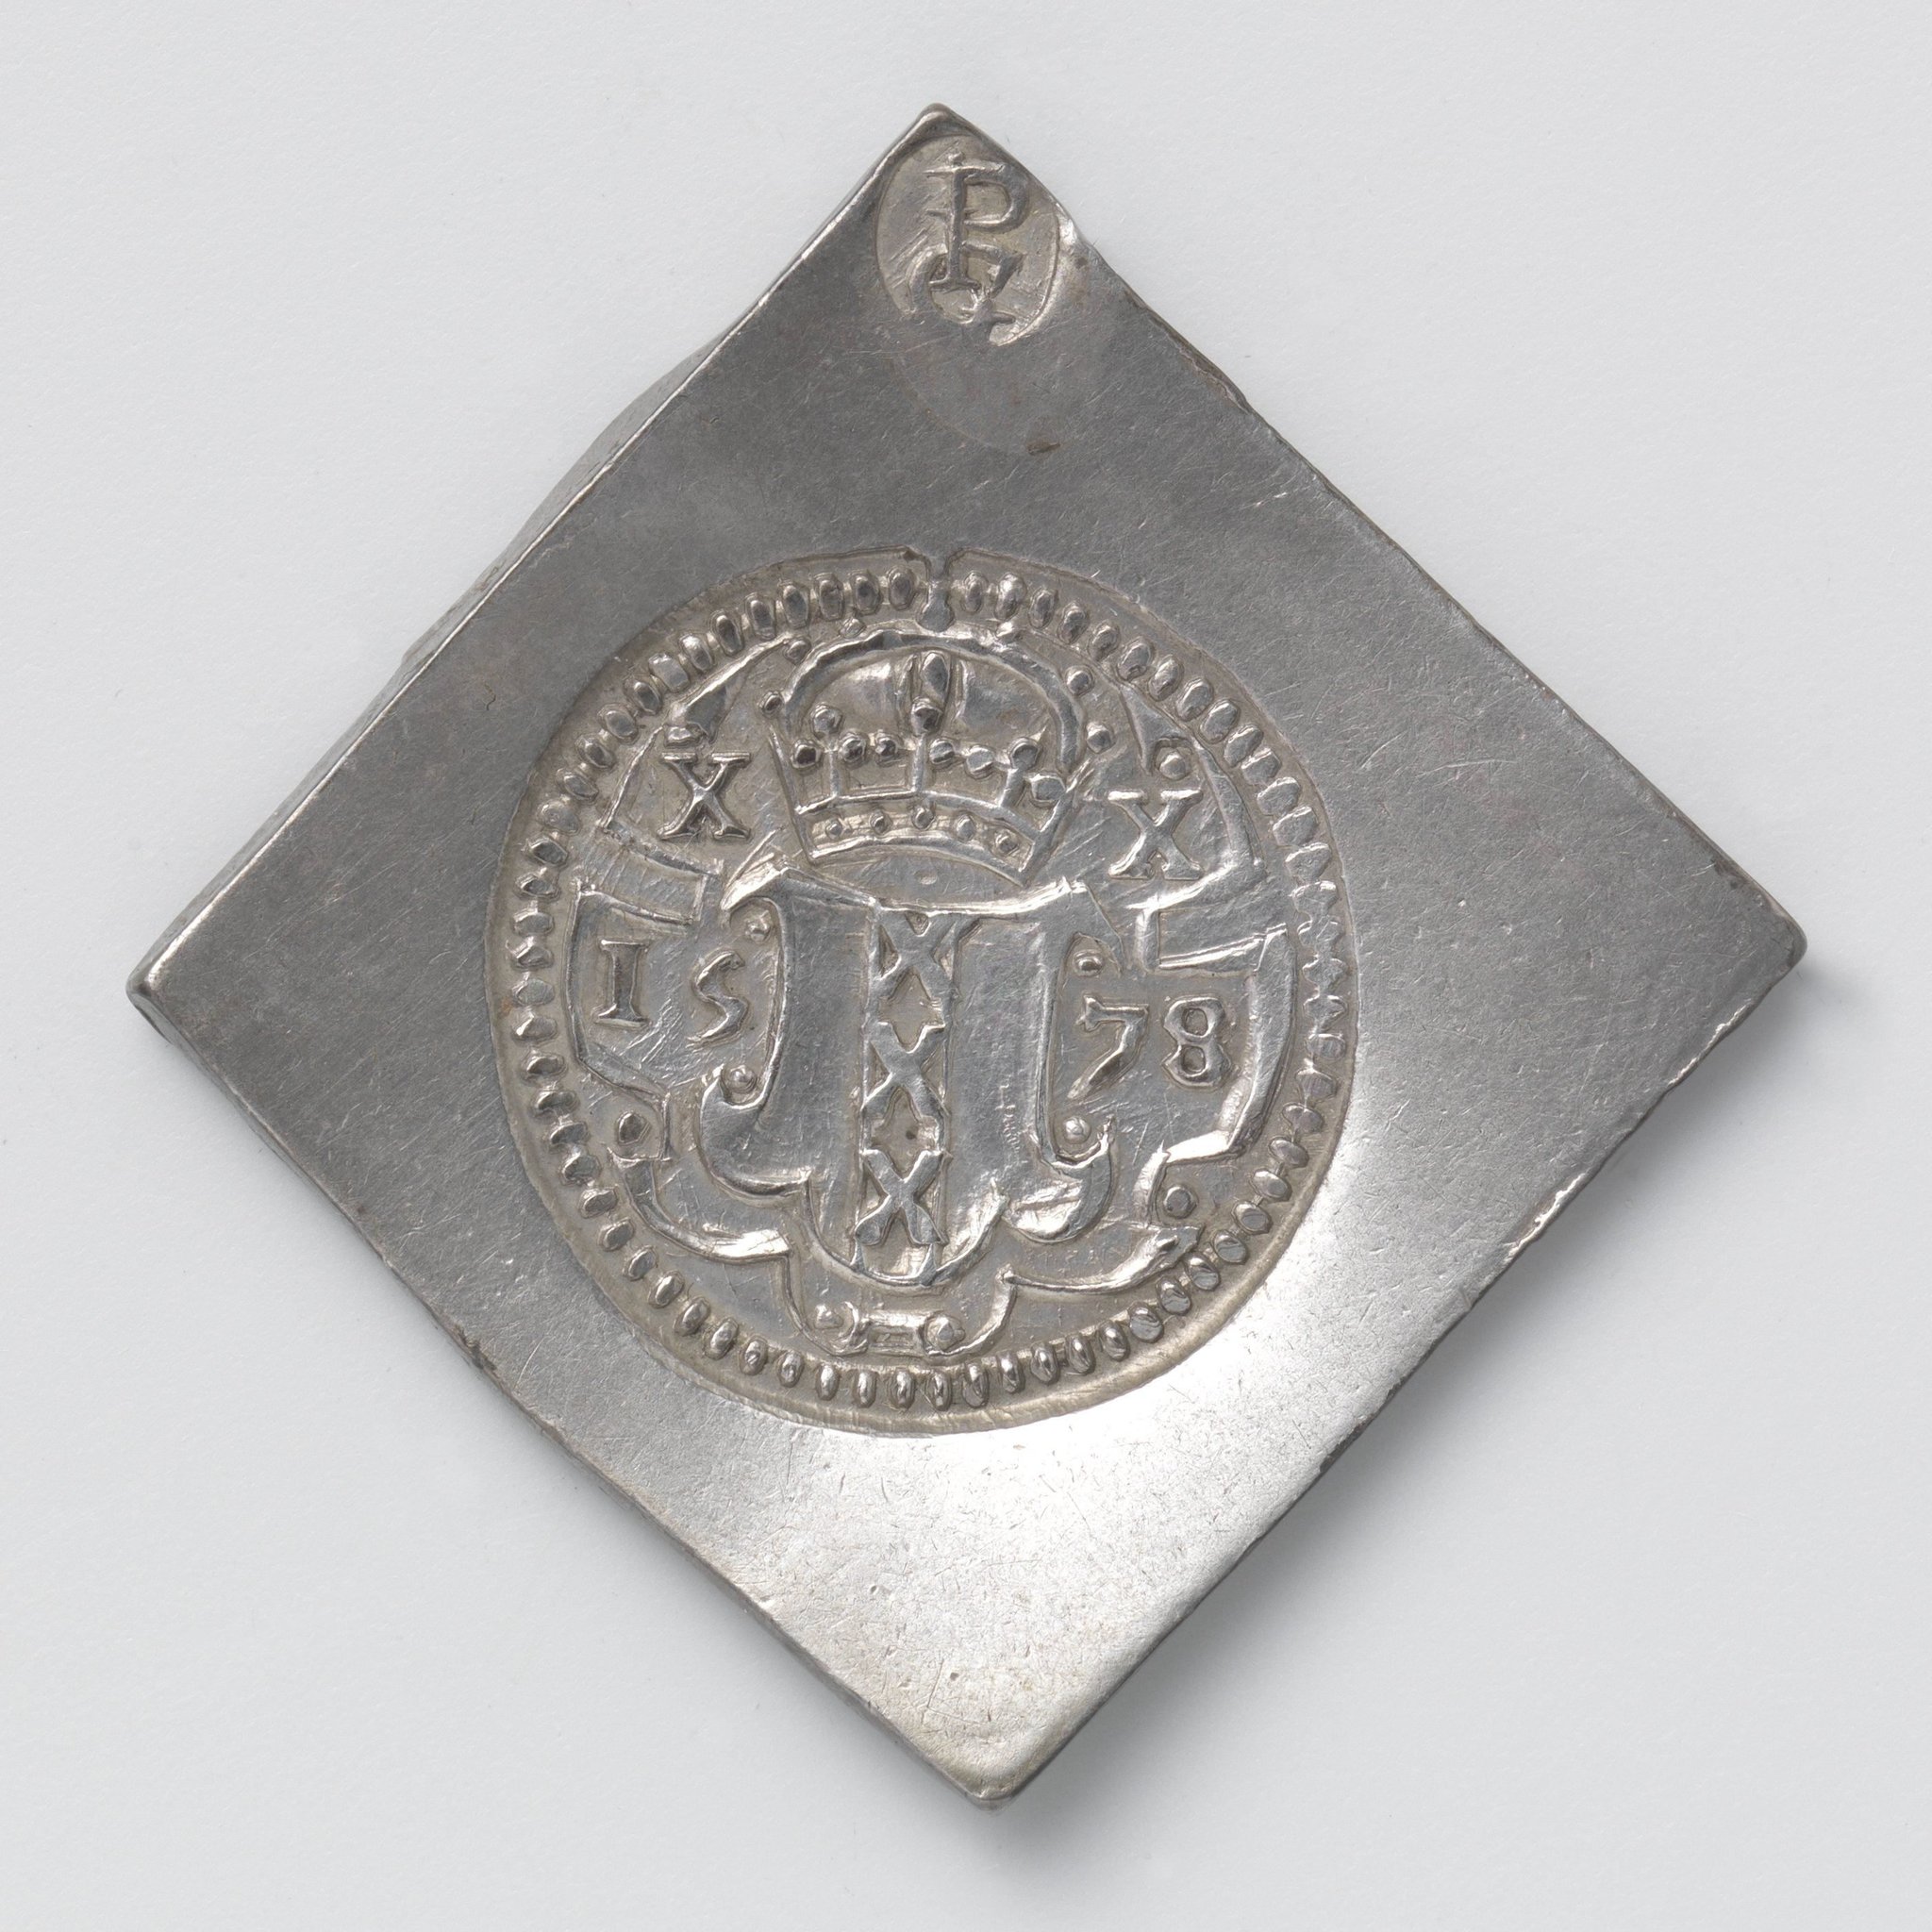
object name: twintig stuiver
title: Twintig stuiver, noodmunt uit Amsterdam, geslagen tijdens het beleg uit het stedelijke zilver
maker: roelant goverts pigge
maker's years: 1534-1606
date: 1578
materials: silver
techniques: striking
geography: amsterdam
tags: amsterdam